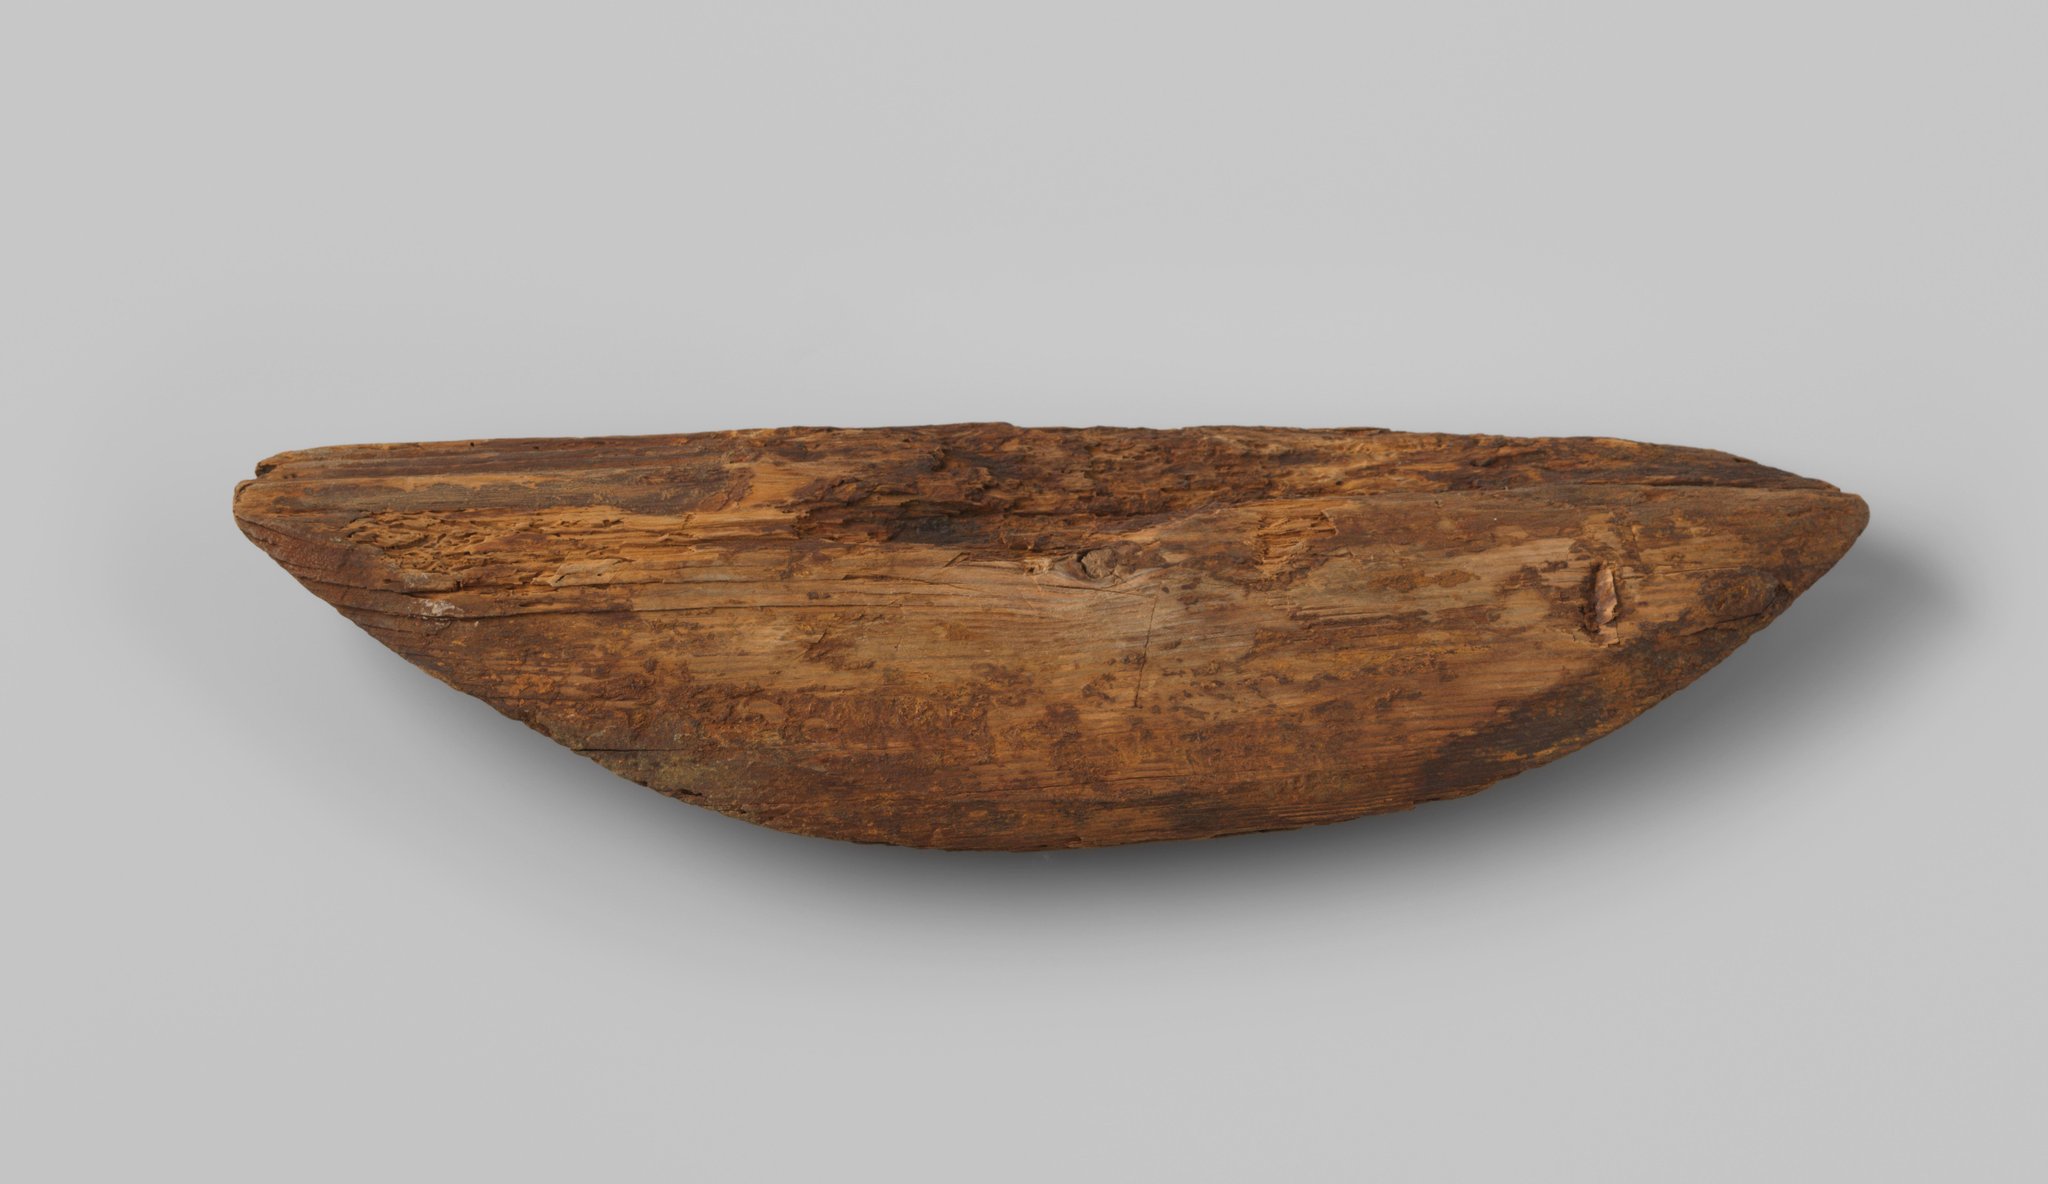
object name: vessel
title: Fragment deksel van een vat uit het wrak van de Oost-Indiëvaarder Hollandia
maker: Anonymous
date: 1700-1743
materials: wood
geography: netherlands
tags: verenigde oostindische compagnie, hollandia (schip), annet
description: Barrel, lid; fragm, semicircular outline bevelled edge on both sides, V-shaped in section.